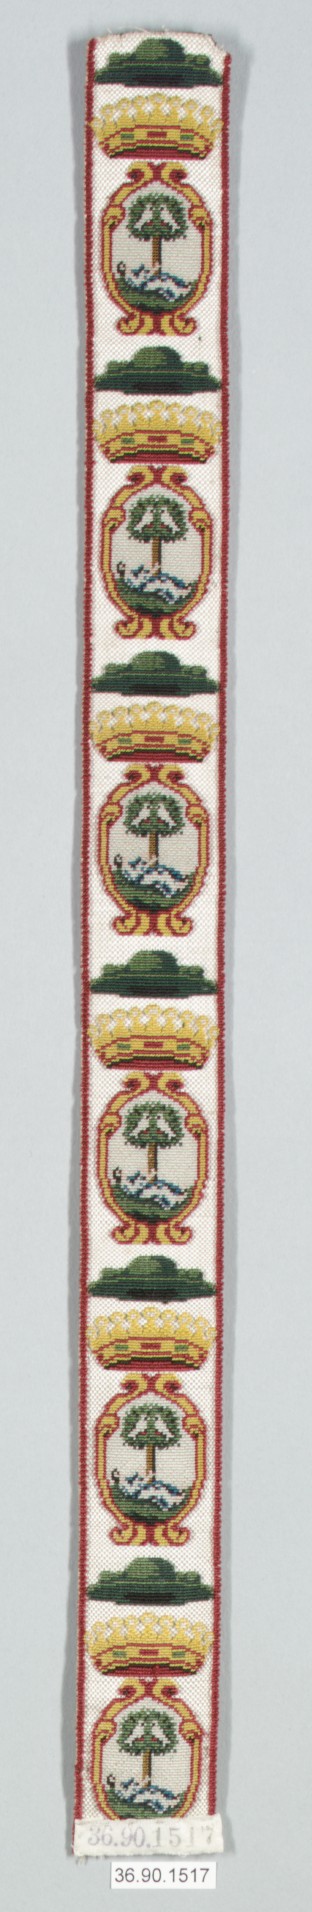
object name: galloon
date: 1701-1900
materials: silk